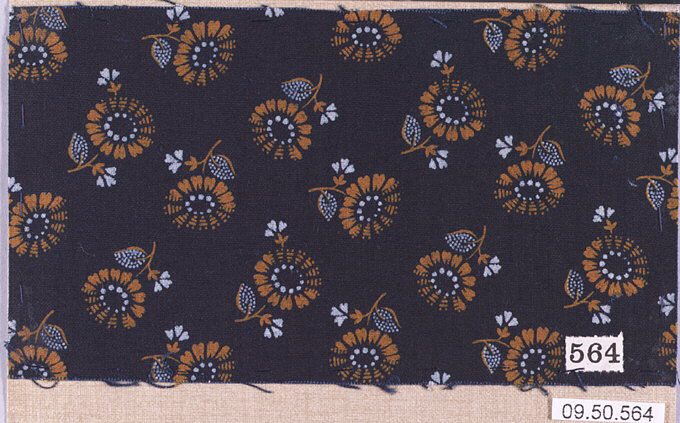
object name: piece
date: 1801-1900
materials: cotton